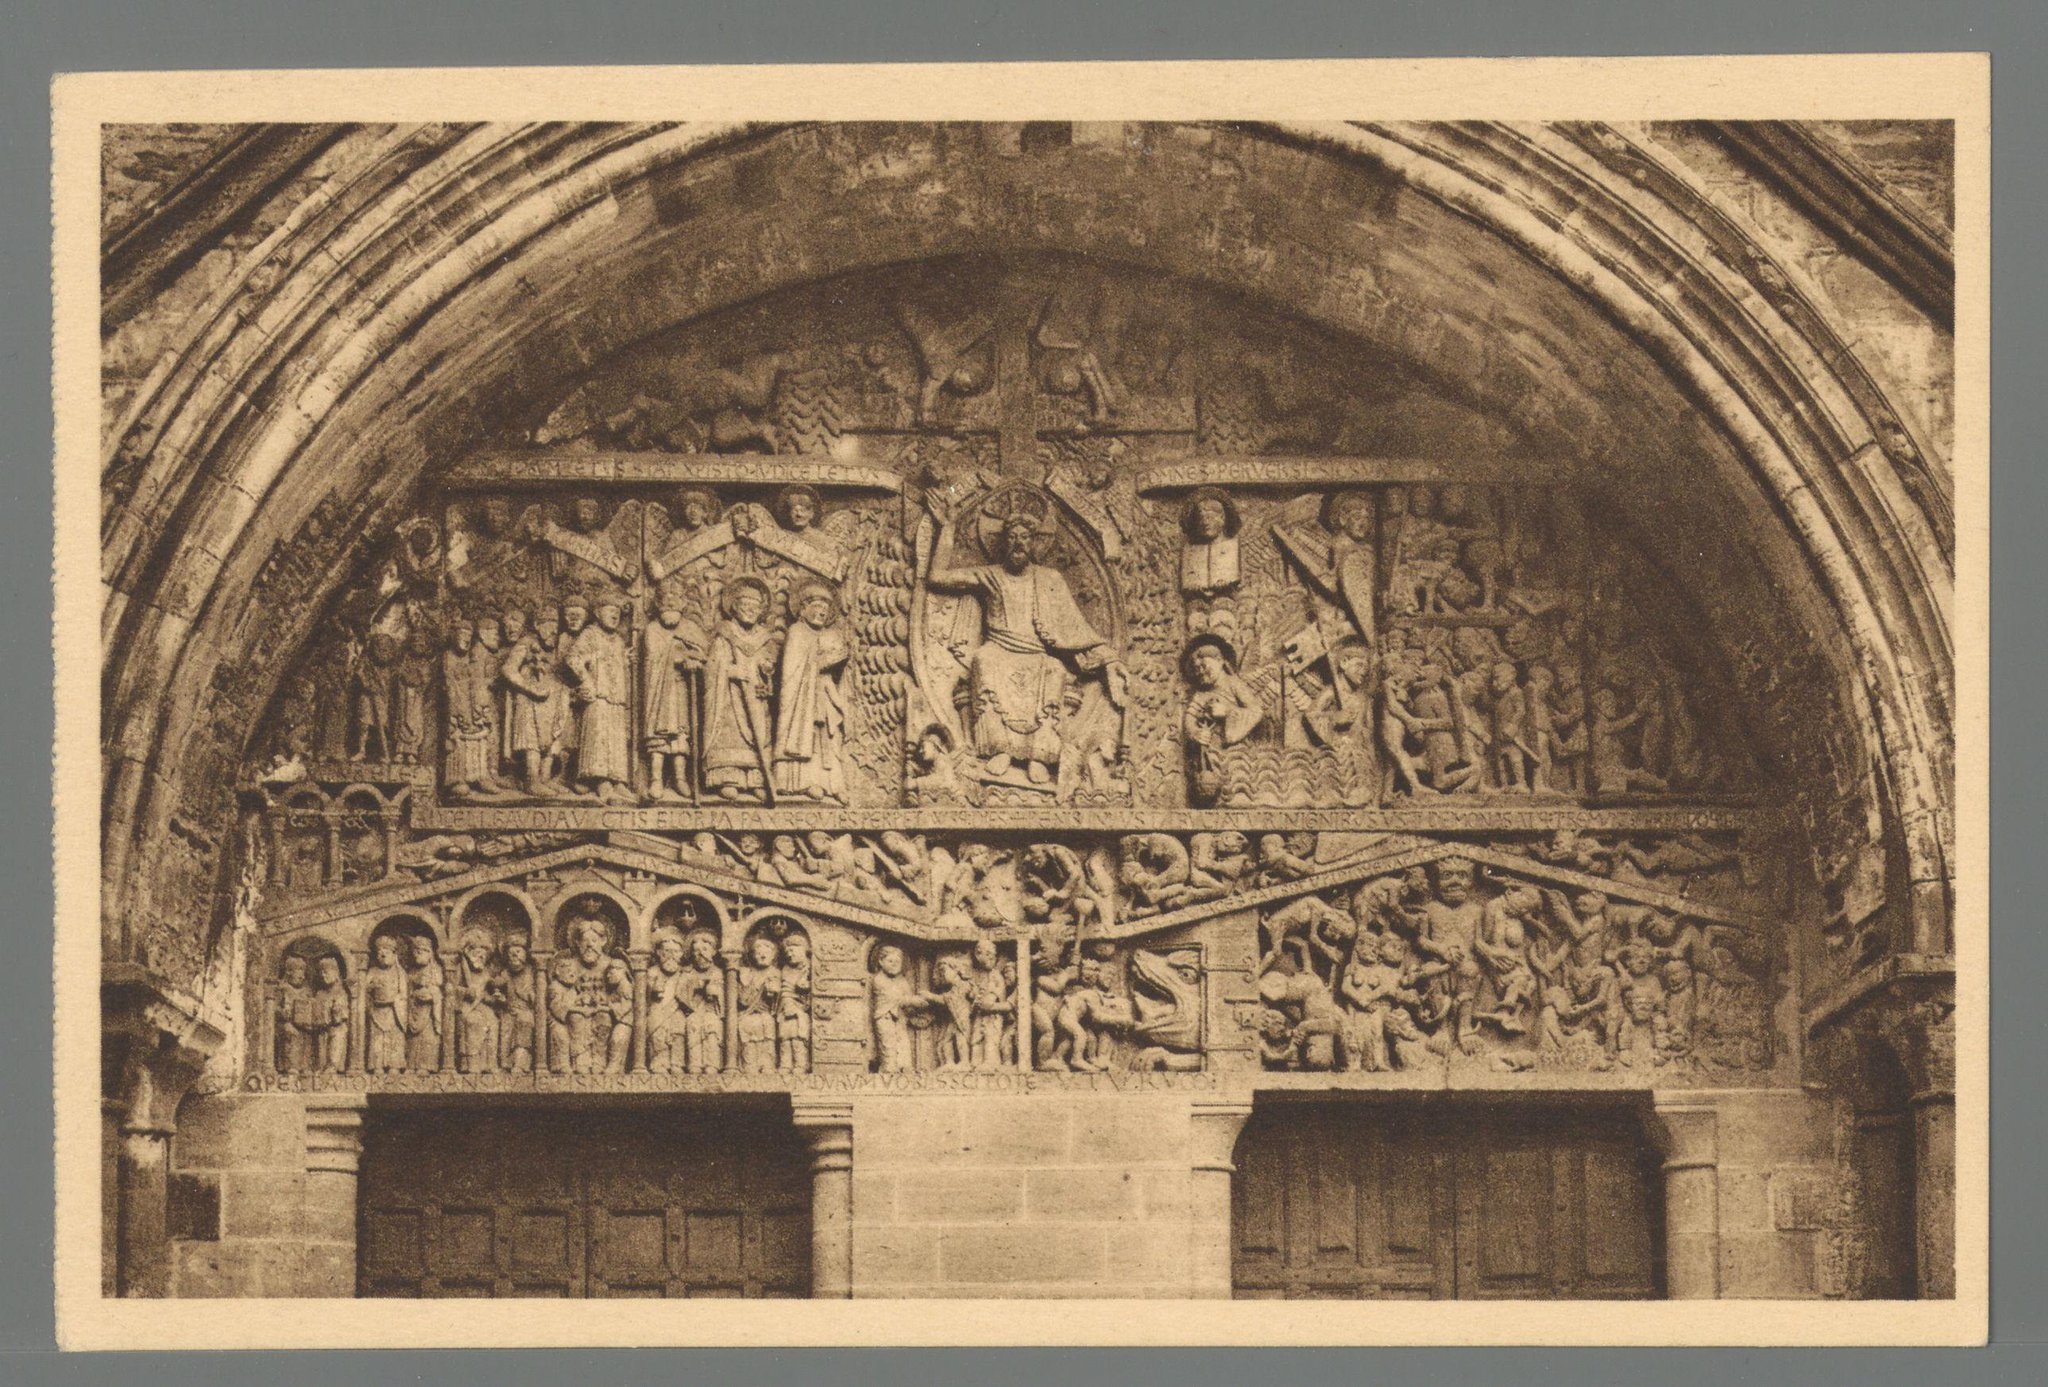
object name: photomechanical print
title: Conques. Tympan de l'Église Ste Foy (XIe s). Le Jugement Dernier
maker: Anonymous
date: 1903-1940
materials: cardboard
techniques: photograph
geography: conques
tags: parts of church exterior and annexes: tympanum